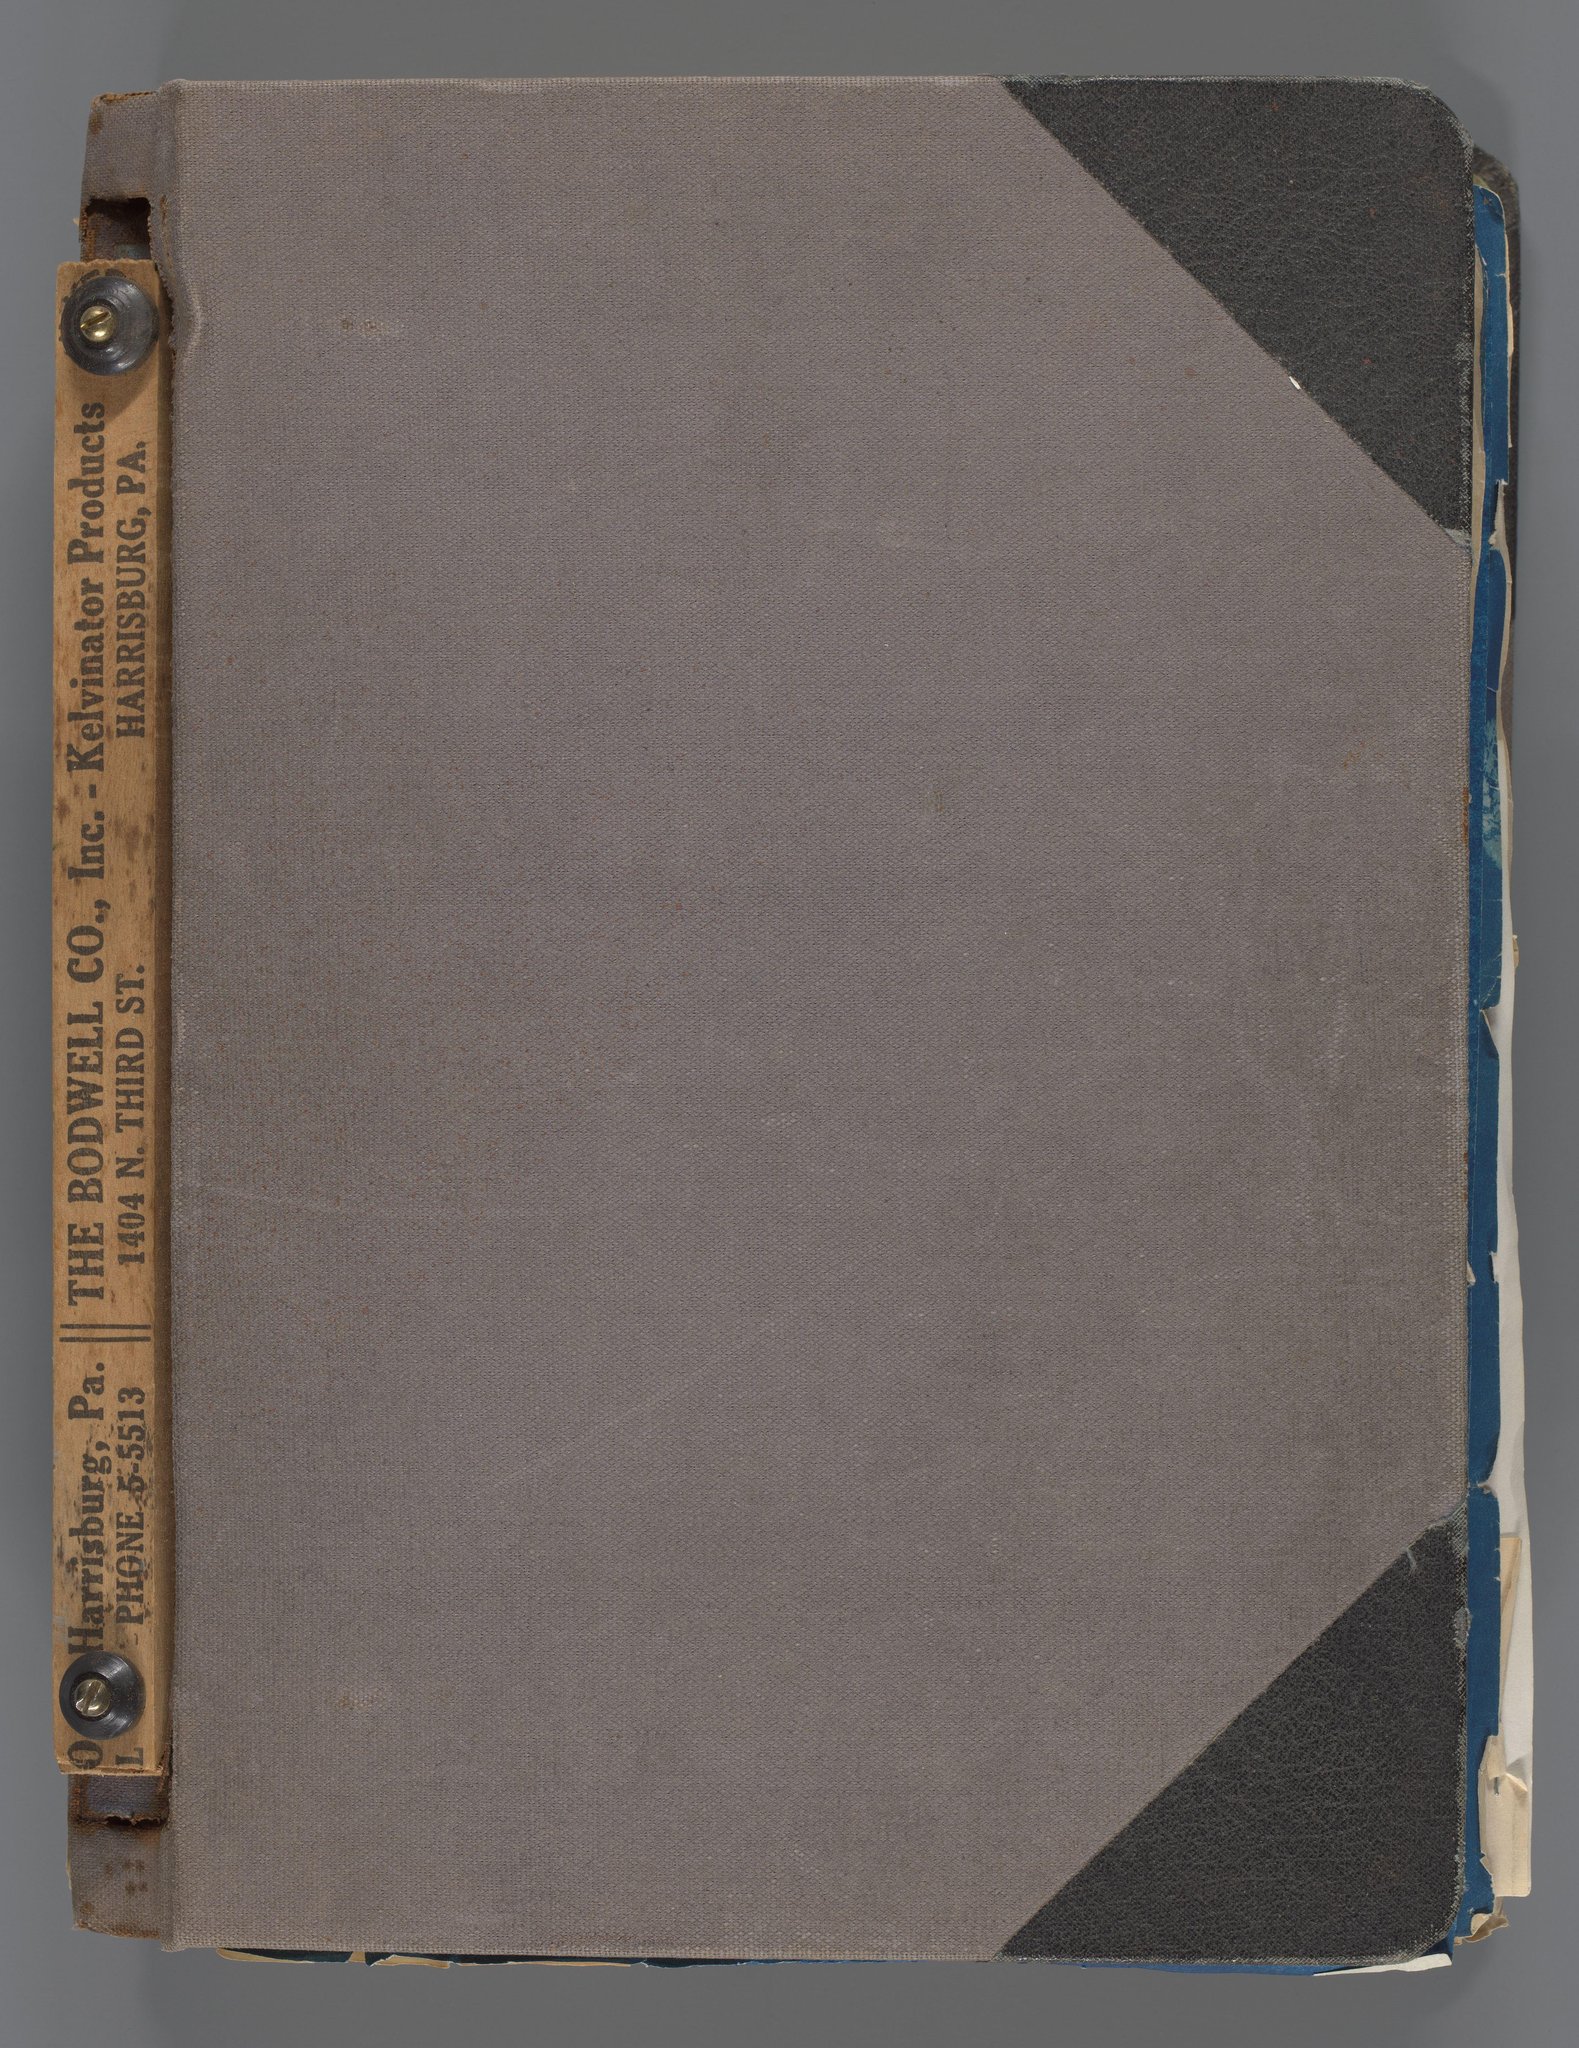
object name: photograph album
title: Album met informatie over Texaco benzinestations in de staat New York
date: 1937-1938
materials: paper, cardboard, iron, textile, wood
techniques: blueprint, gelatin silver print, pen, typewriting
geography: norwich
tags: petrol pump, service station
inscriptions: address: ‘Harrisburg, Pa./ PHONE 5-5513/ THE BODWELL CO., Inc. - Kelvinator Products/ 1404 N. THIRD ST. HARRISBURG, PA.’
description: Album met informatie over Texaco benzinestations en distributielocaties in de staat New York, waaronder foto's, blauwdrukken en eigendomsgegevens. Samengesteld door administrateurs S.G. Higley en A.J. McLoughlin (tevens fotograaf) met taxateur E.W. Jones, in opdracht van eigenaar Z & M Independent Oil Company uit Norwich, New York. Het album bevat steeds 2 tot 12 foto's per pagina (73 pagina's, 320 foto's in totaal).